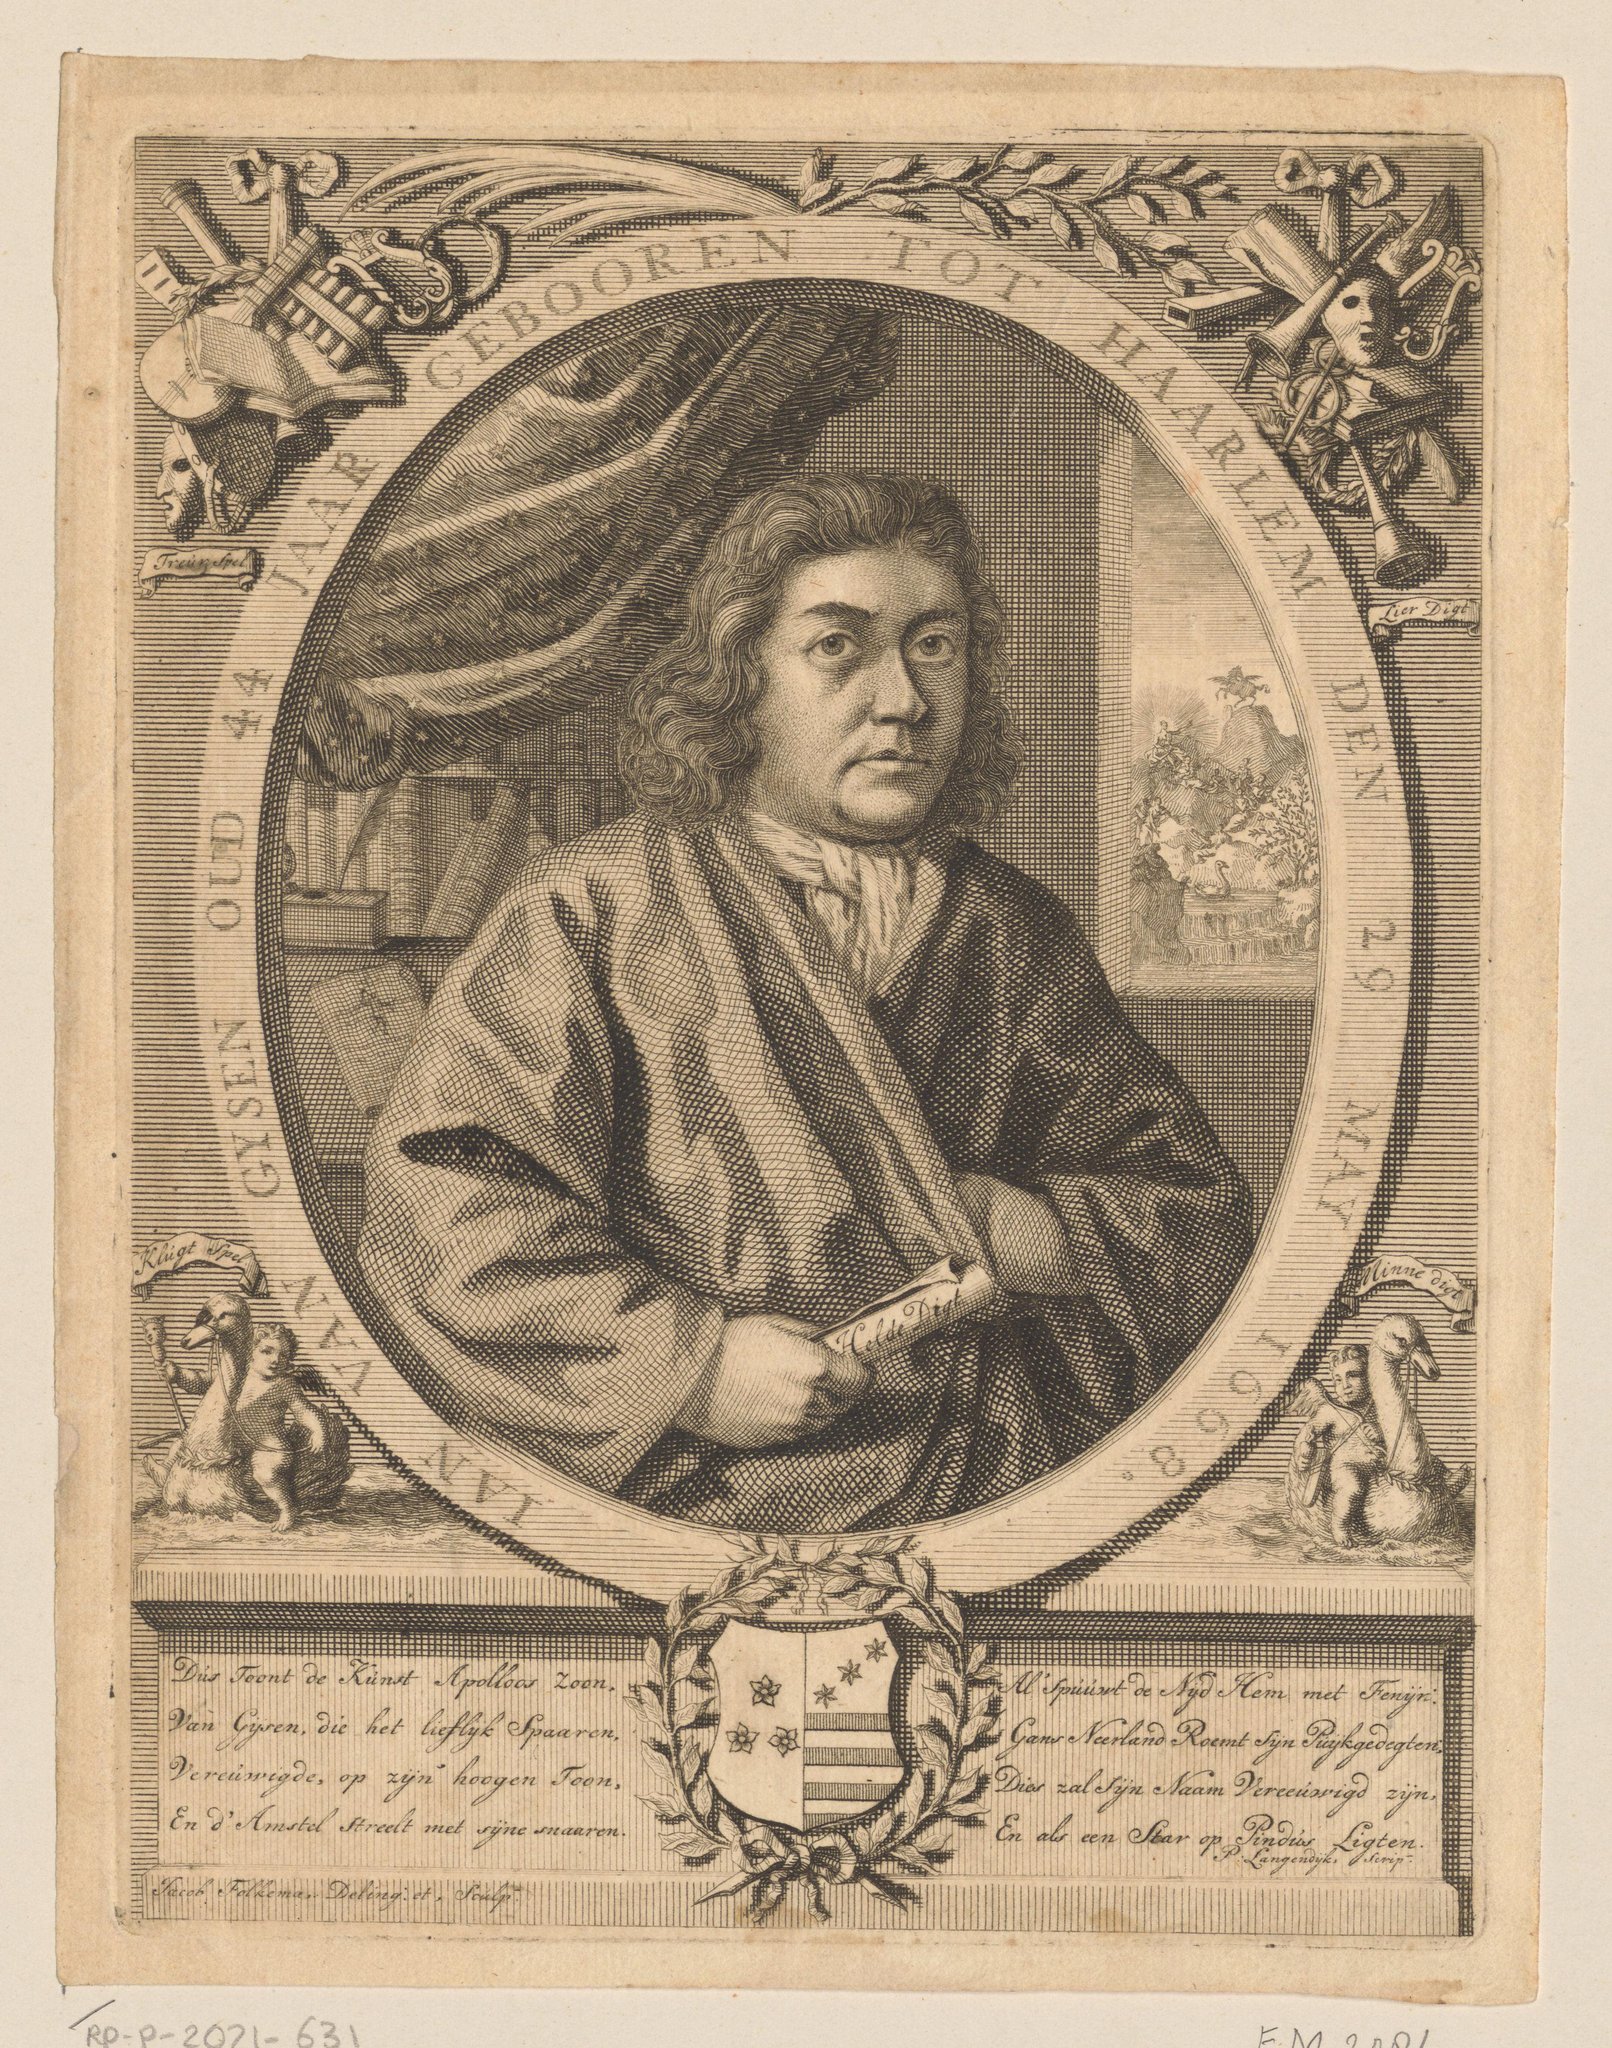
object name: print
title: Portret van Jan van Gijsen op 44-jarige leeftijd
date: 1712-1767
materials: paper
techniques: engraving, etching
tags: amsterdam, jan van gijsen, historical persons, writer, poet, author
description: Tekst in het Nederlands in de ondermarge en in de omlijsting.